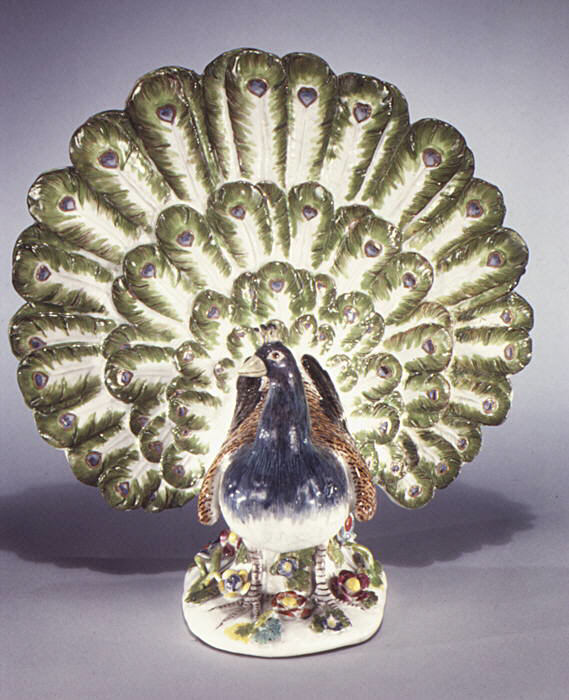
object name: figure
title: Peacock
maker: meissen manufactory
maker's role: manufactory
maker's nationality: german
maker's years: 1710-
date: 1741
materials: hard paste porcelain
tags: peacocks